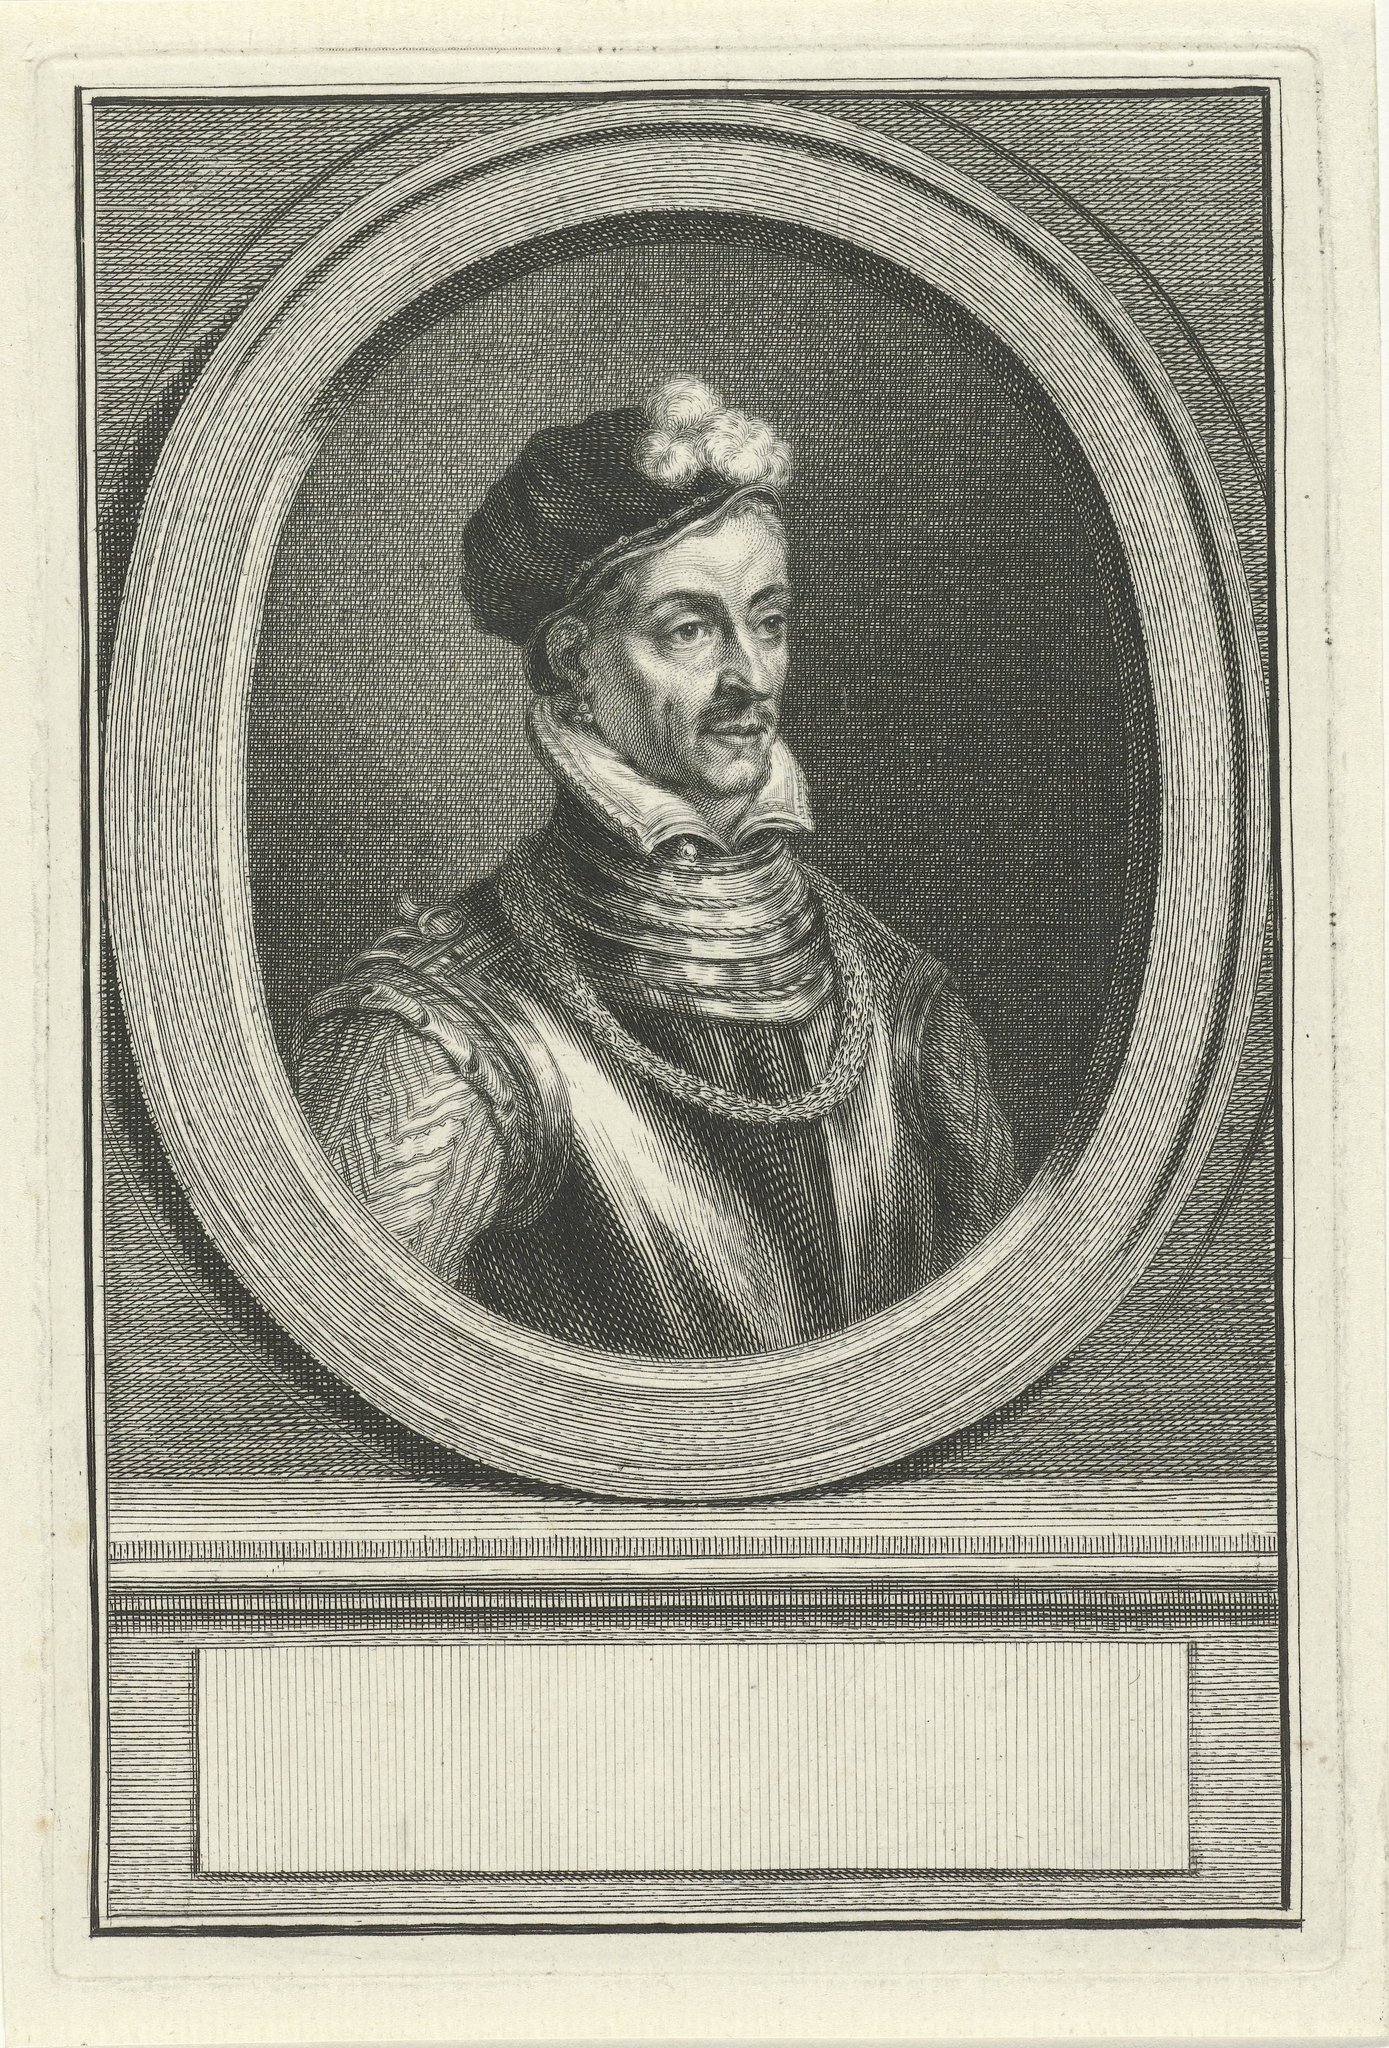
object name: print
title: Portret van Johan van der Does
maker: jacob houbraken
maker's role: draughtsman, print maker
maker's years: 1698-1780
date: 1747-1759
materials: paper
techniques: engraving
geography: amsterdam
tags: bevelhebber, bibliothecaris, bestuurder, jan van der does (heer van noordwijk en kattendijke)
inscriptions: collector's mark: Lugt 240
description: Proefdruk van de prent gebruikt in: Jan Wagenaar, Vaderlandsche historie, vervattende de geschiedenissen der nu Vereenigde Nederlanden, inzonderheid die van Holland (...), 21 delen. Amsterdam, Isaak Tirion, 1749-59.